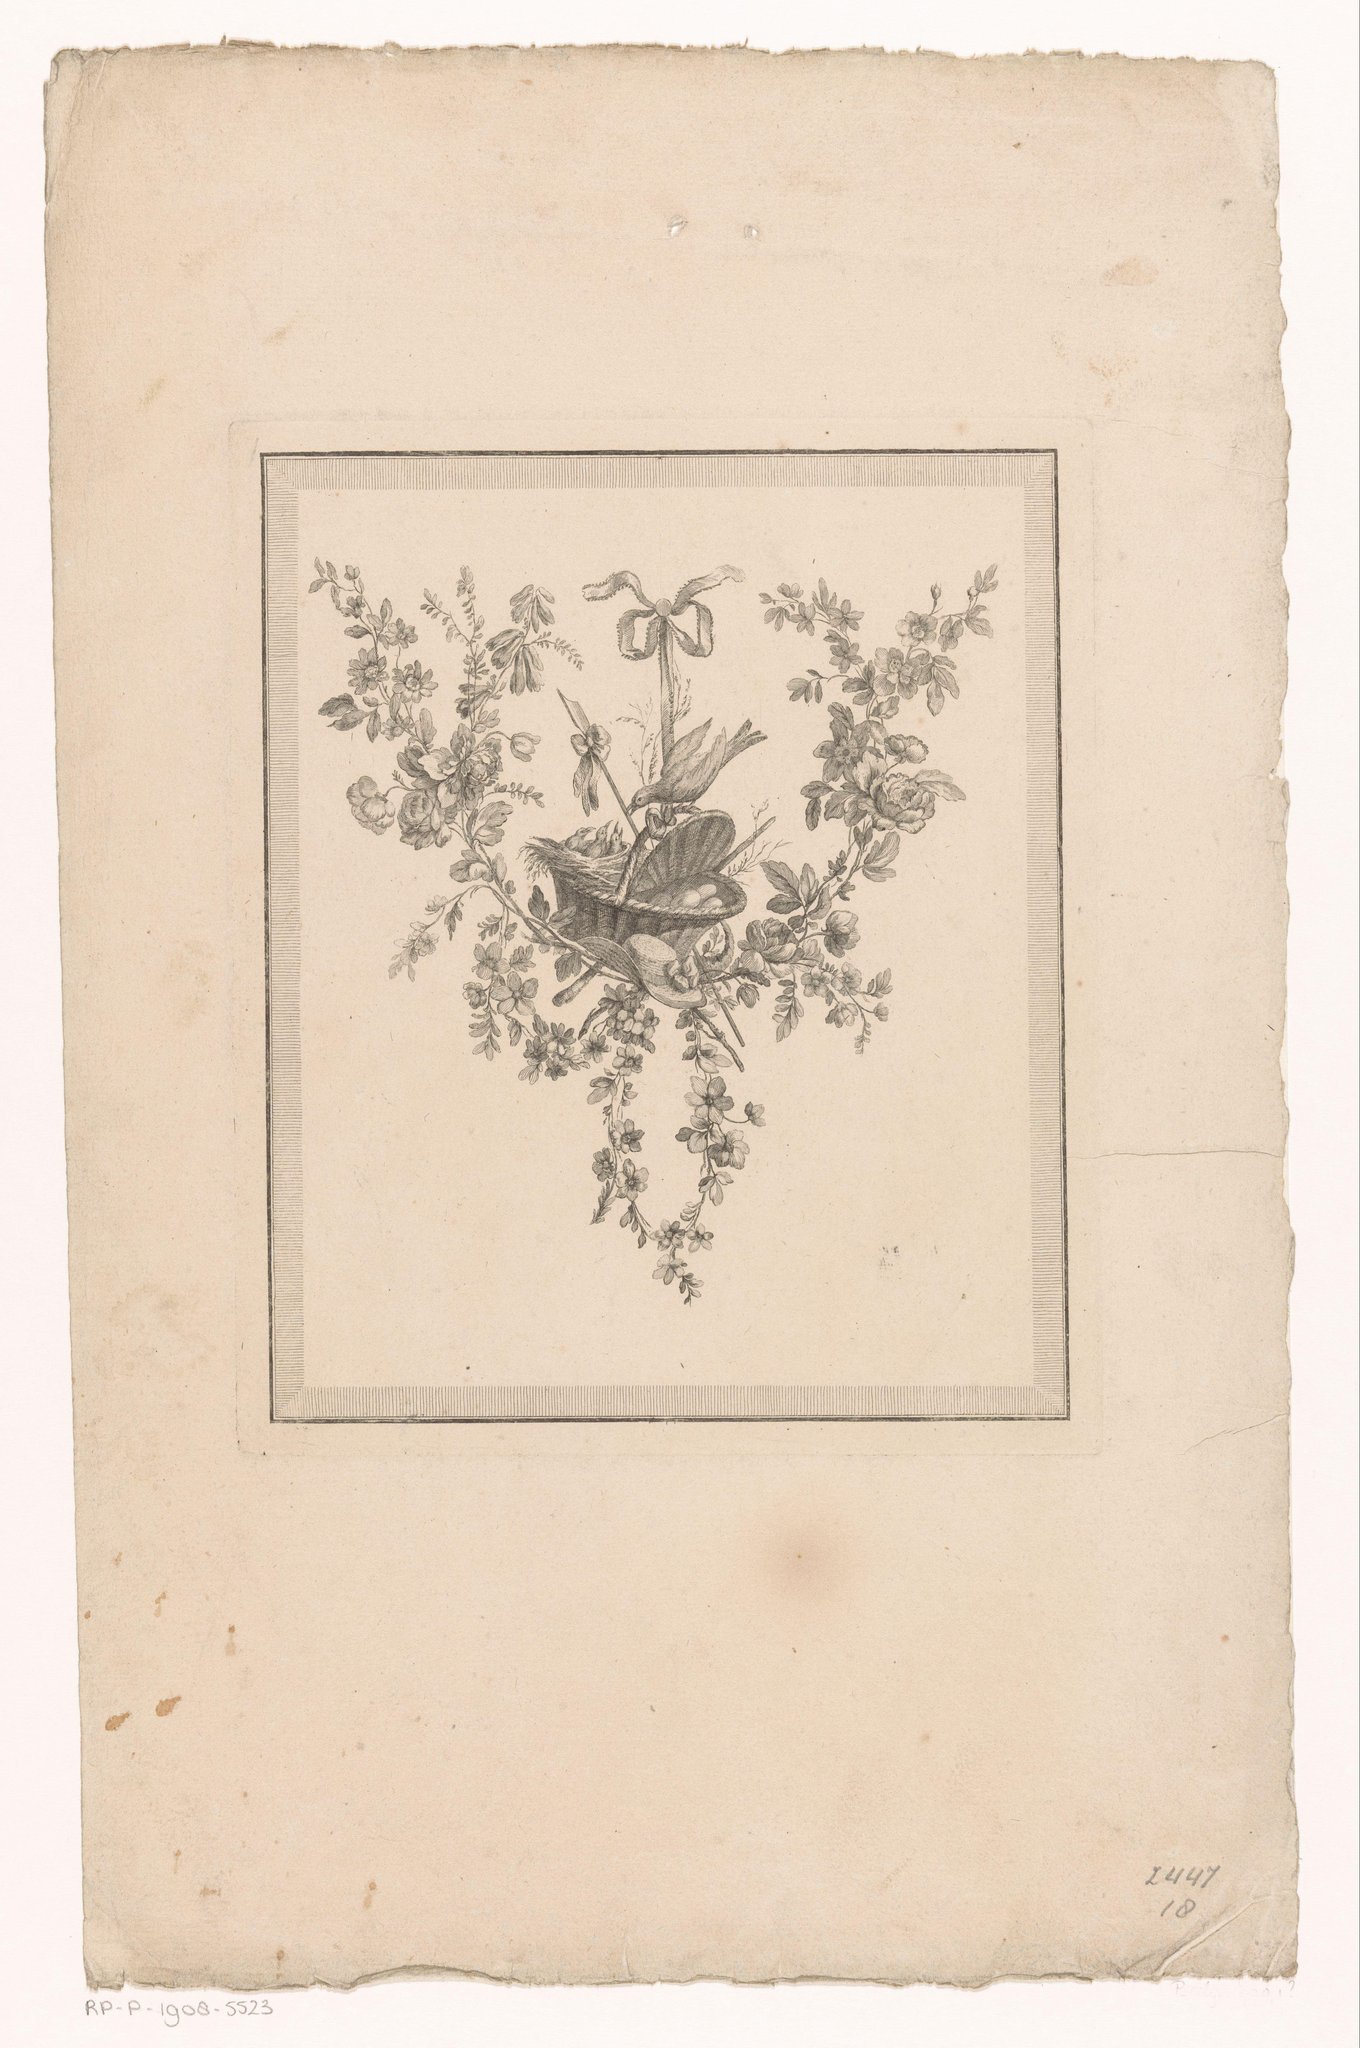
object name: print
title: Trofee met mand met vogels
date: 1746-1786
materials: paper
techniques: etching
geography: france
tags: trophy, i.e.: decorative arrangement of symbolic or typical objects ~ ornament, birds, container made of plant material other than wood: basket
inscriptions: collector's mark: Lugt 2228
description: Een trofee met een vogel op een mand met kuikens en eieren. Daarbij een herdersstaf en -hoed. Rondom een omlijsting van bloemen.